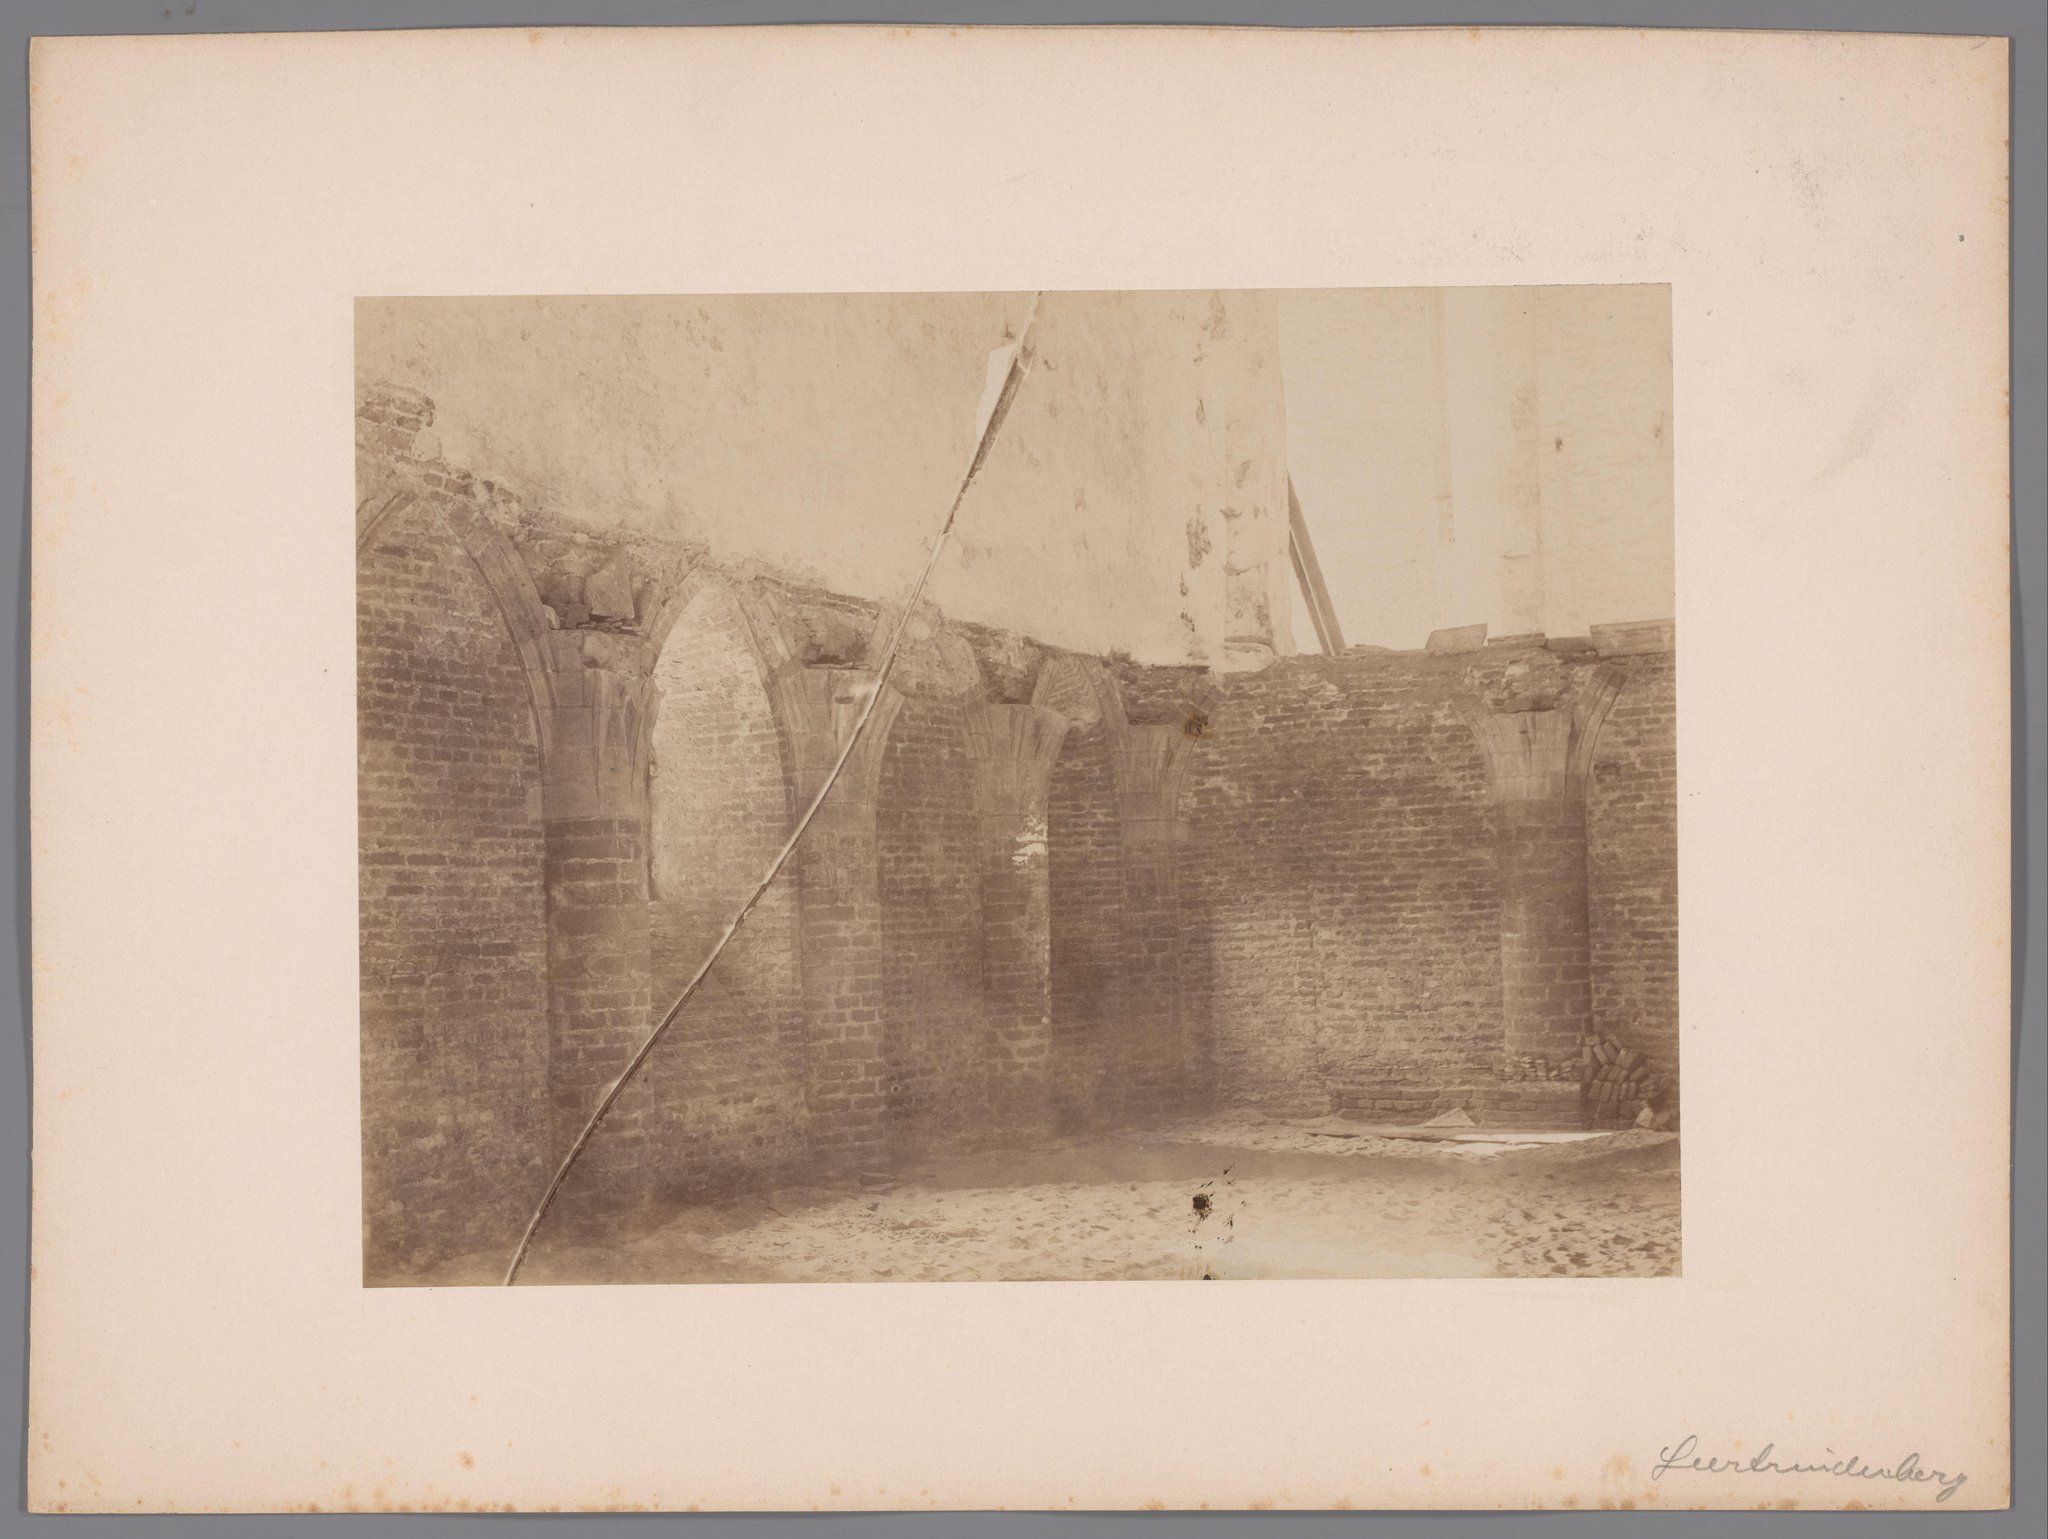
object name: photograph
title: Interieur van een ontgraven crypte in de Geertruidskerk te Geertruidenberg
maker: anoniem (monumentenzorg)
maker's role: fotograaf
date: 1895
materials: cardboard, photographic support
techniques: albumen print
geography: geertruidenberg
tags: parts of church interior (crypt), geertruidenberg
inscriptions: annotation: ‘Geertruidenberg’, annotation: ‘Zuidwest hoek v/d ontgraven krocht in de N.H. Kerk te Geertruidenberg (N.B.)/ oct 1895’